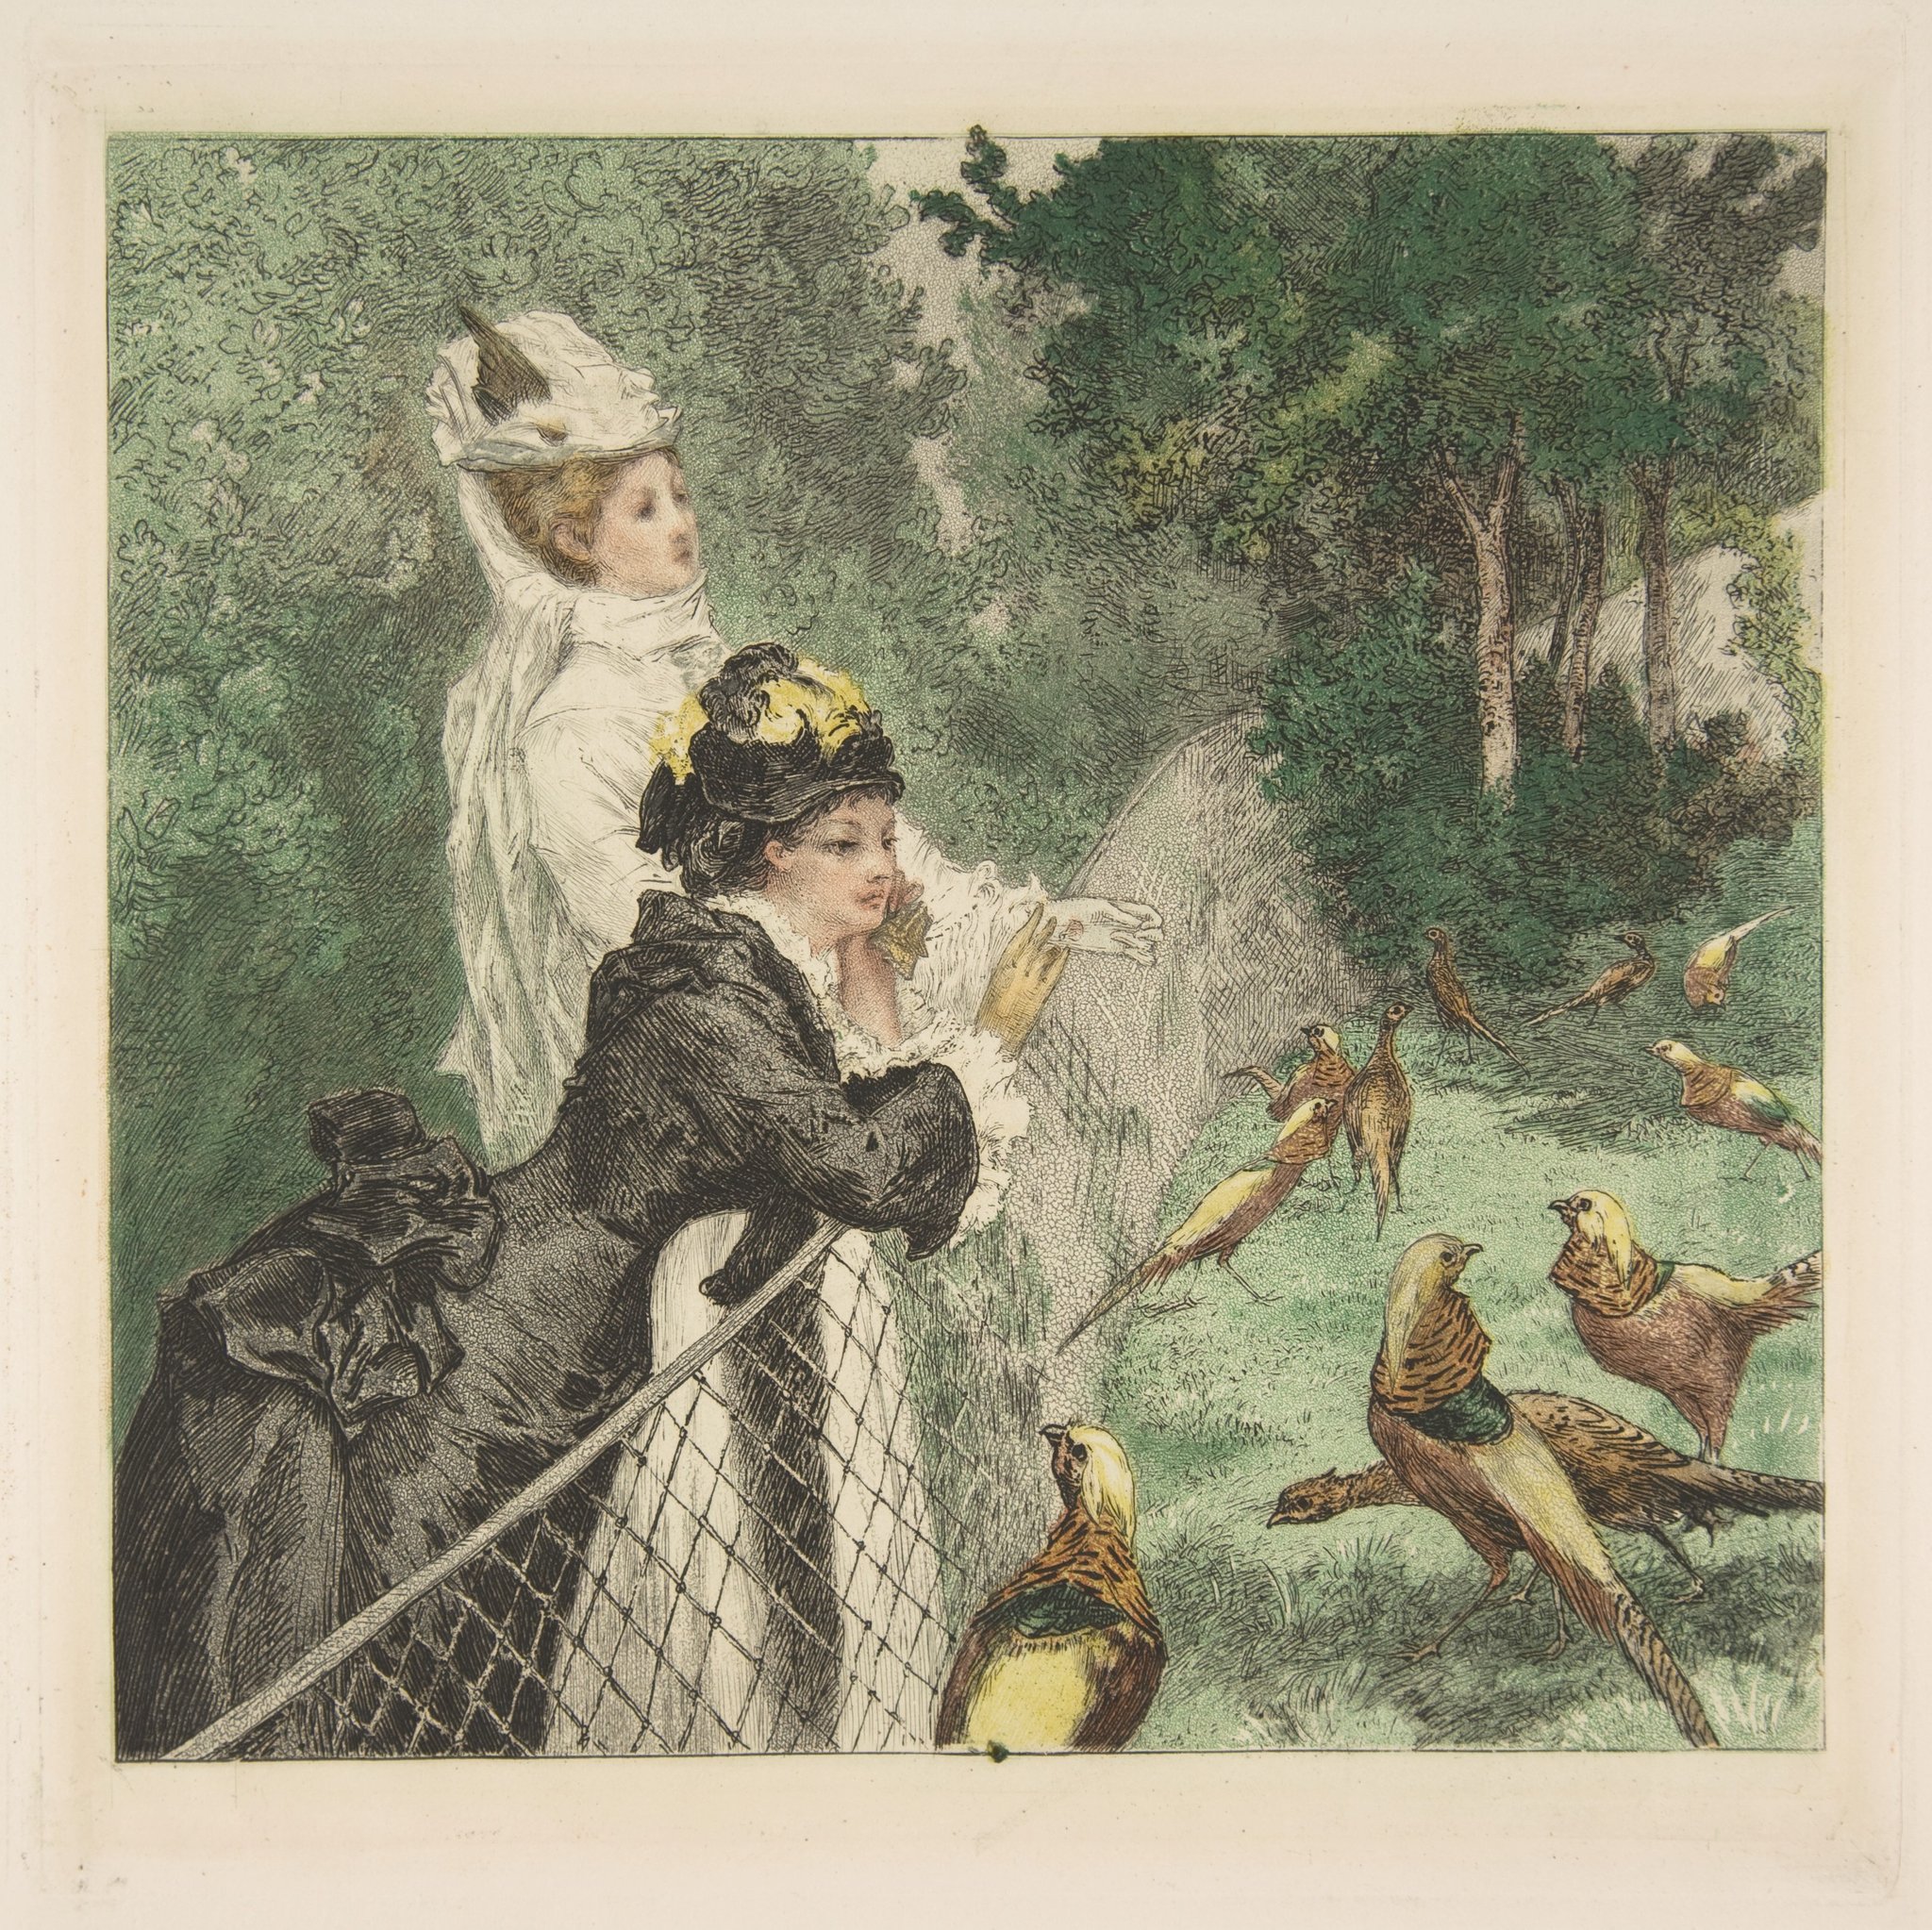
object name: print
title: In the Zoological Garden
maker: félix bracquemond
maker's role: artist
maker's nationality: french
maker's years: 1833-1914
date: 1873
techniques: aquatint, drypoint, etching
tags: birds,gardens,women